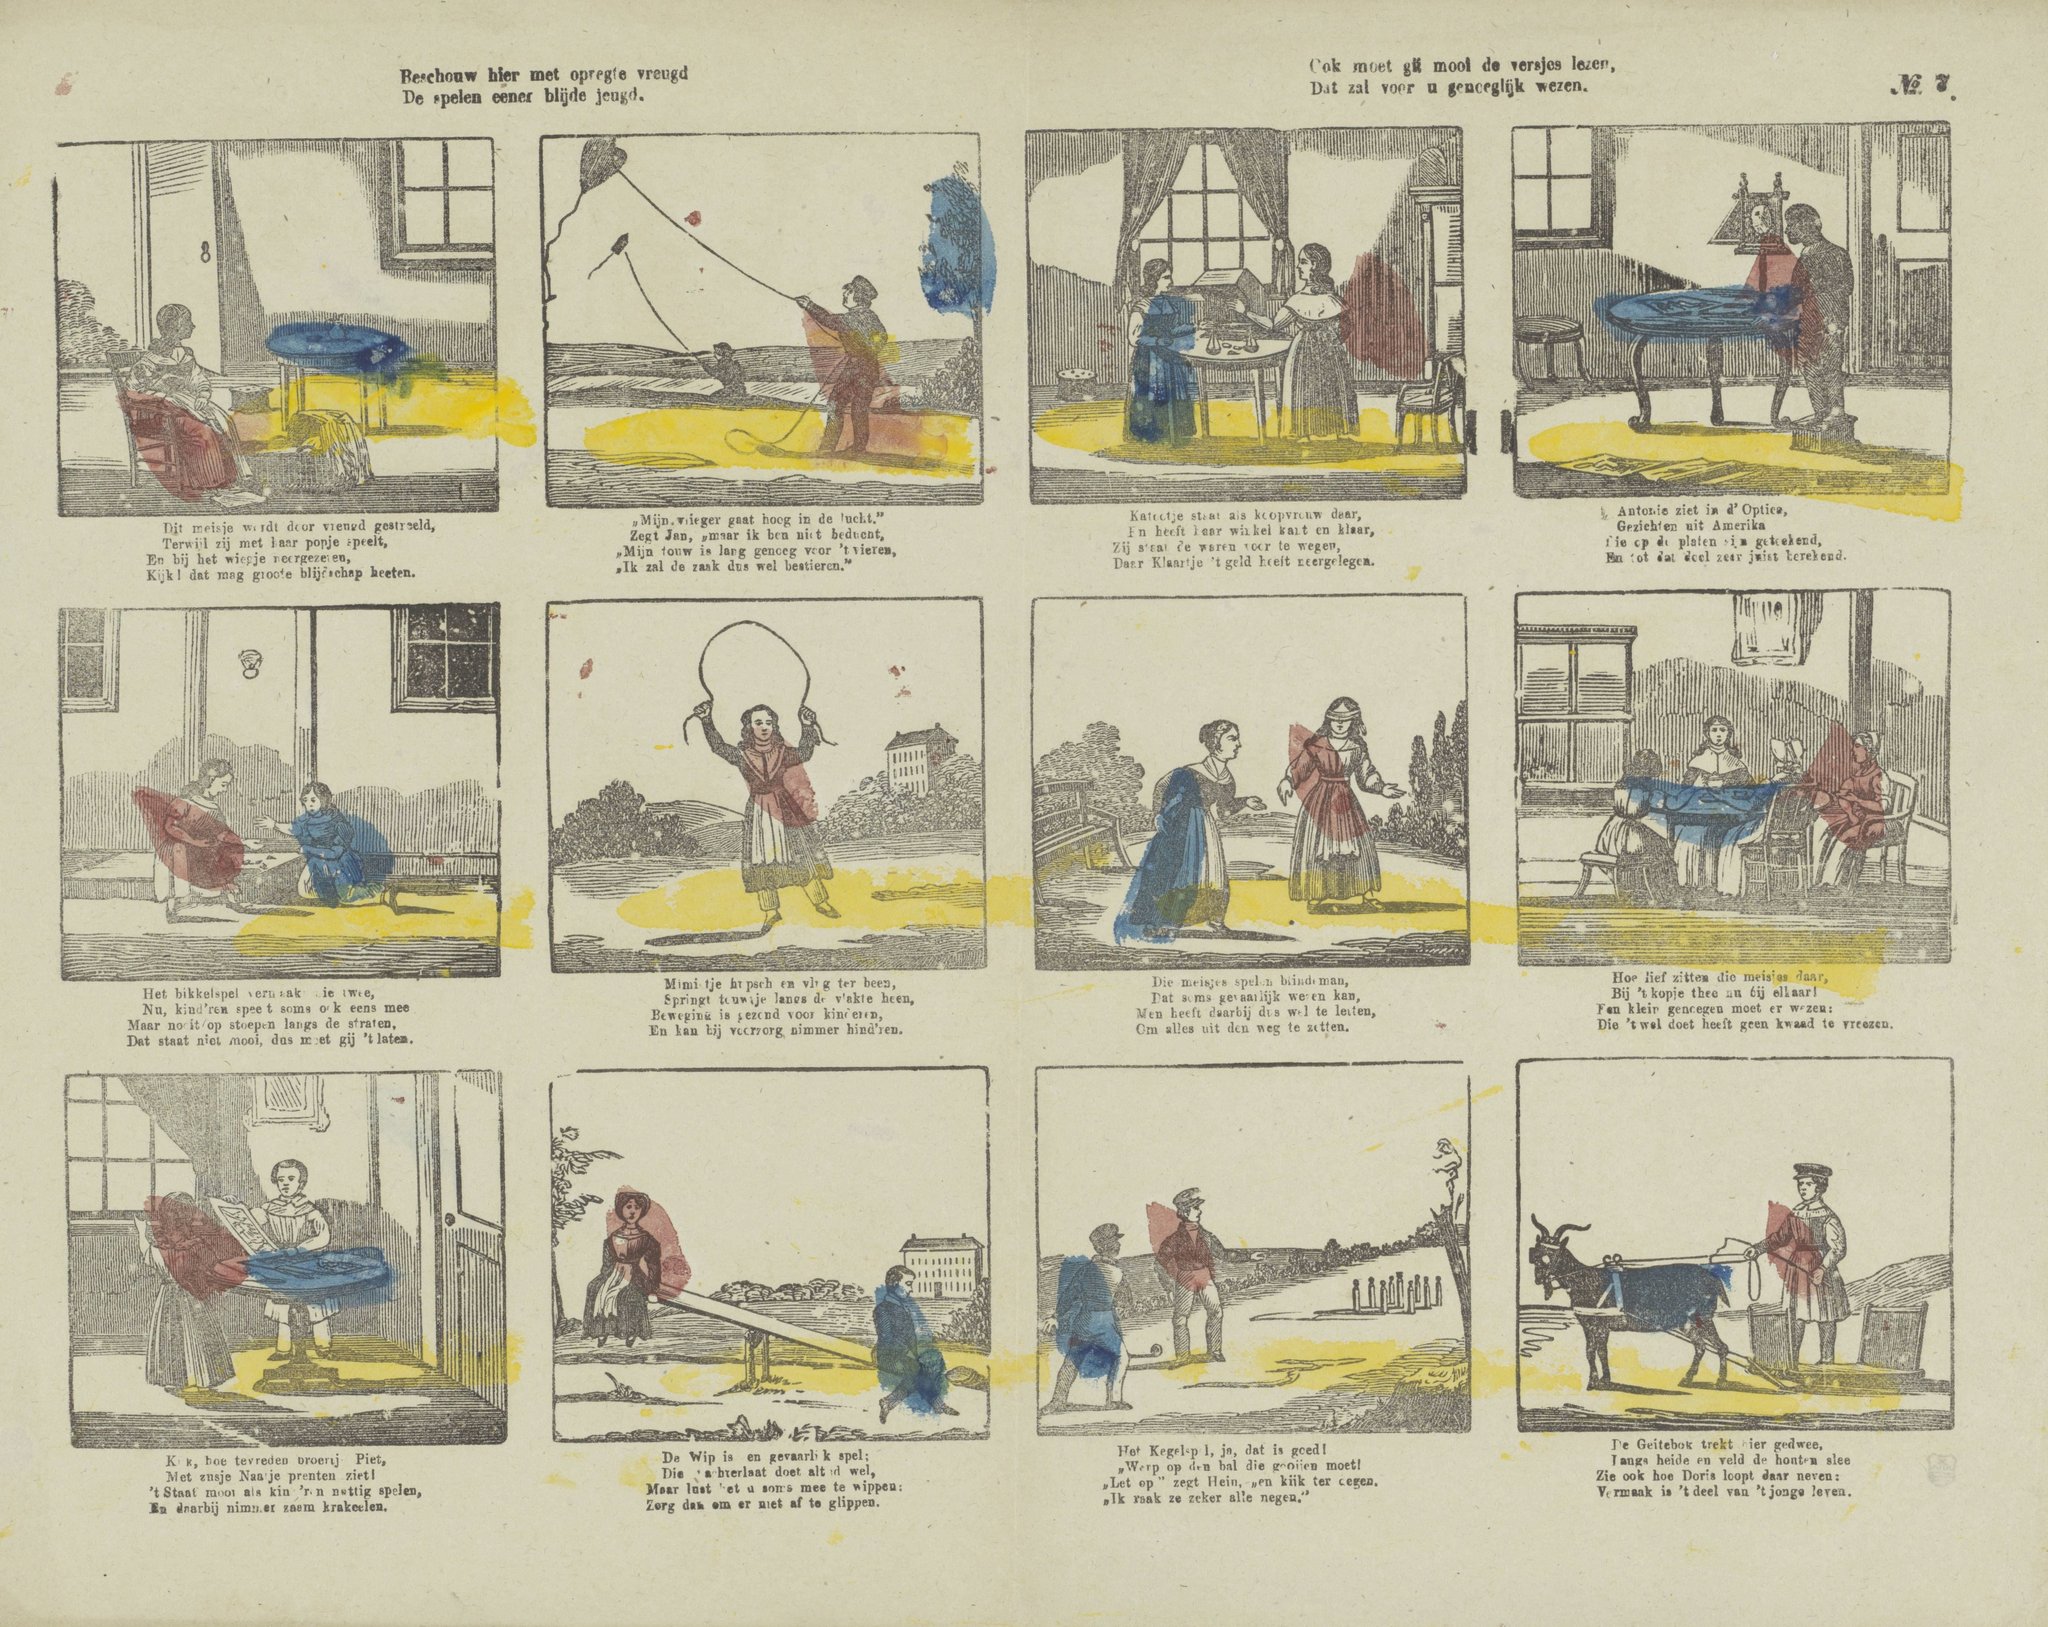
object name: print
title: Beschouw hier met opregte vreugd, / De spelen eener blijde jeugd, / Ook moet gij mooi de versjes lezen. / Dat zal voor u genoeglijk wezen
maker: Anonymous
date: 1850-1870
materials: paper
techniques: colour, letterpress printing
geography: netherlands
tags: children's games and plays, blind-man's buff, (flying a) kite, jumping-rope games, seesaw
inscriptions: collector's mark: Lugt 2760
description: Blad met 12 voorstellingen van kinderspelen en bezigheden, zoals vliegeren, touwtjespringen en blindemannetje. Onder elke afbeelding een vierregelig vers. Rechtsboven genummerd: No. 7.